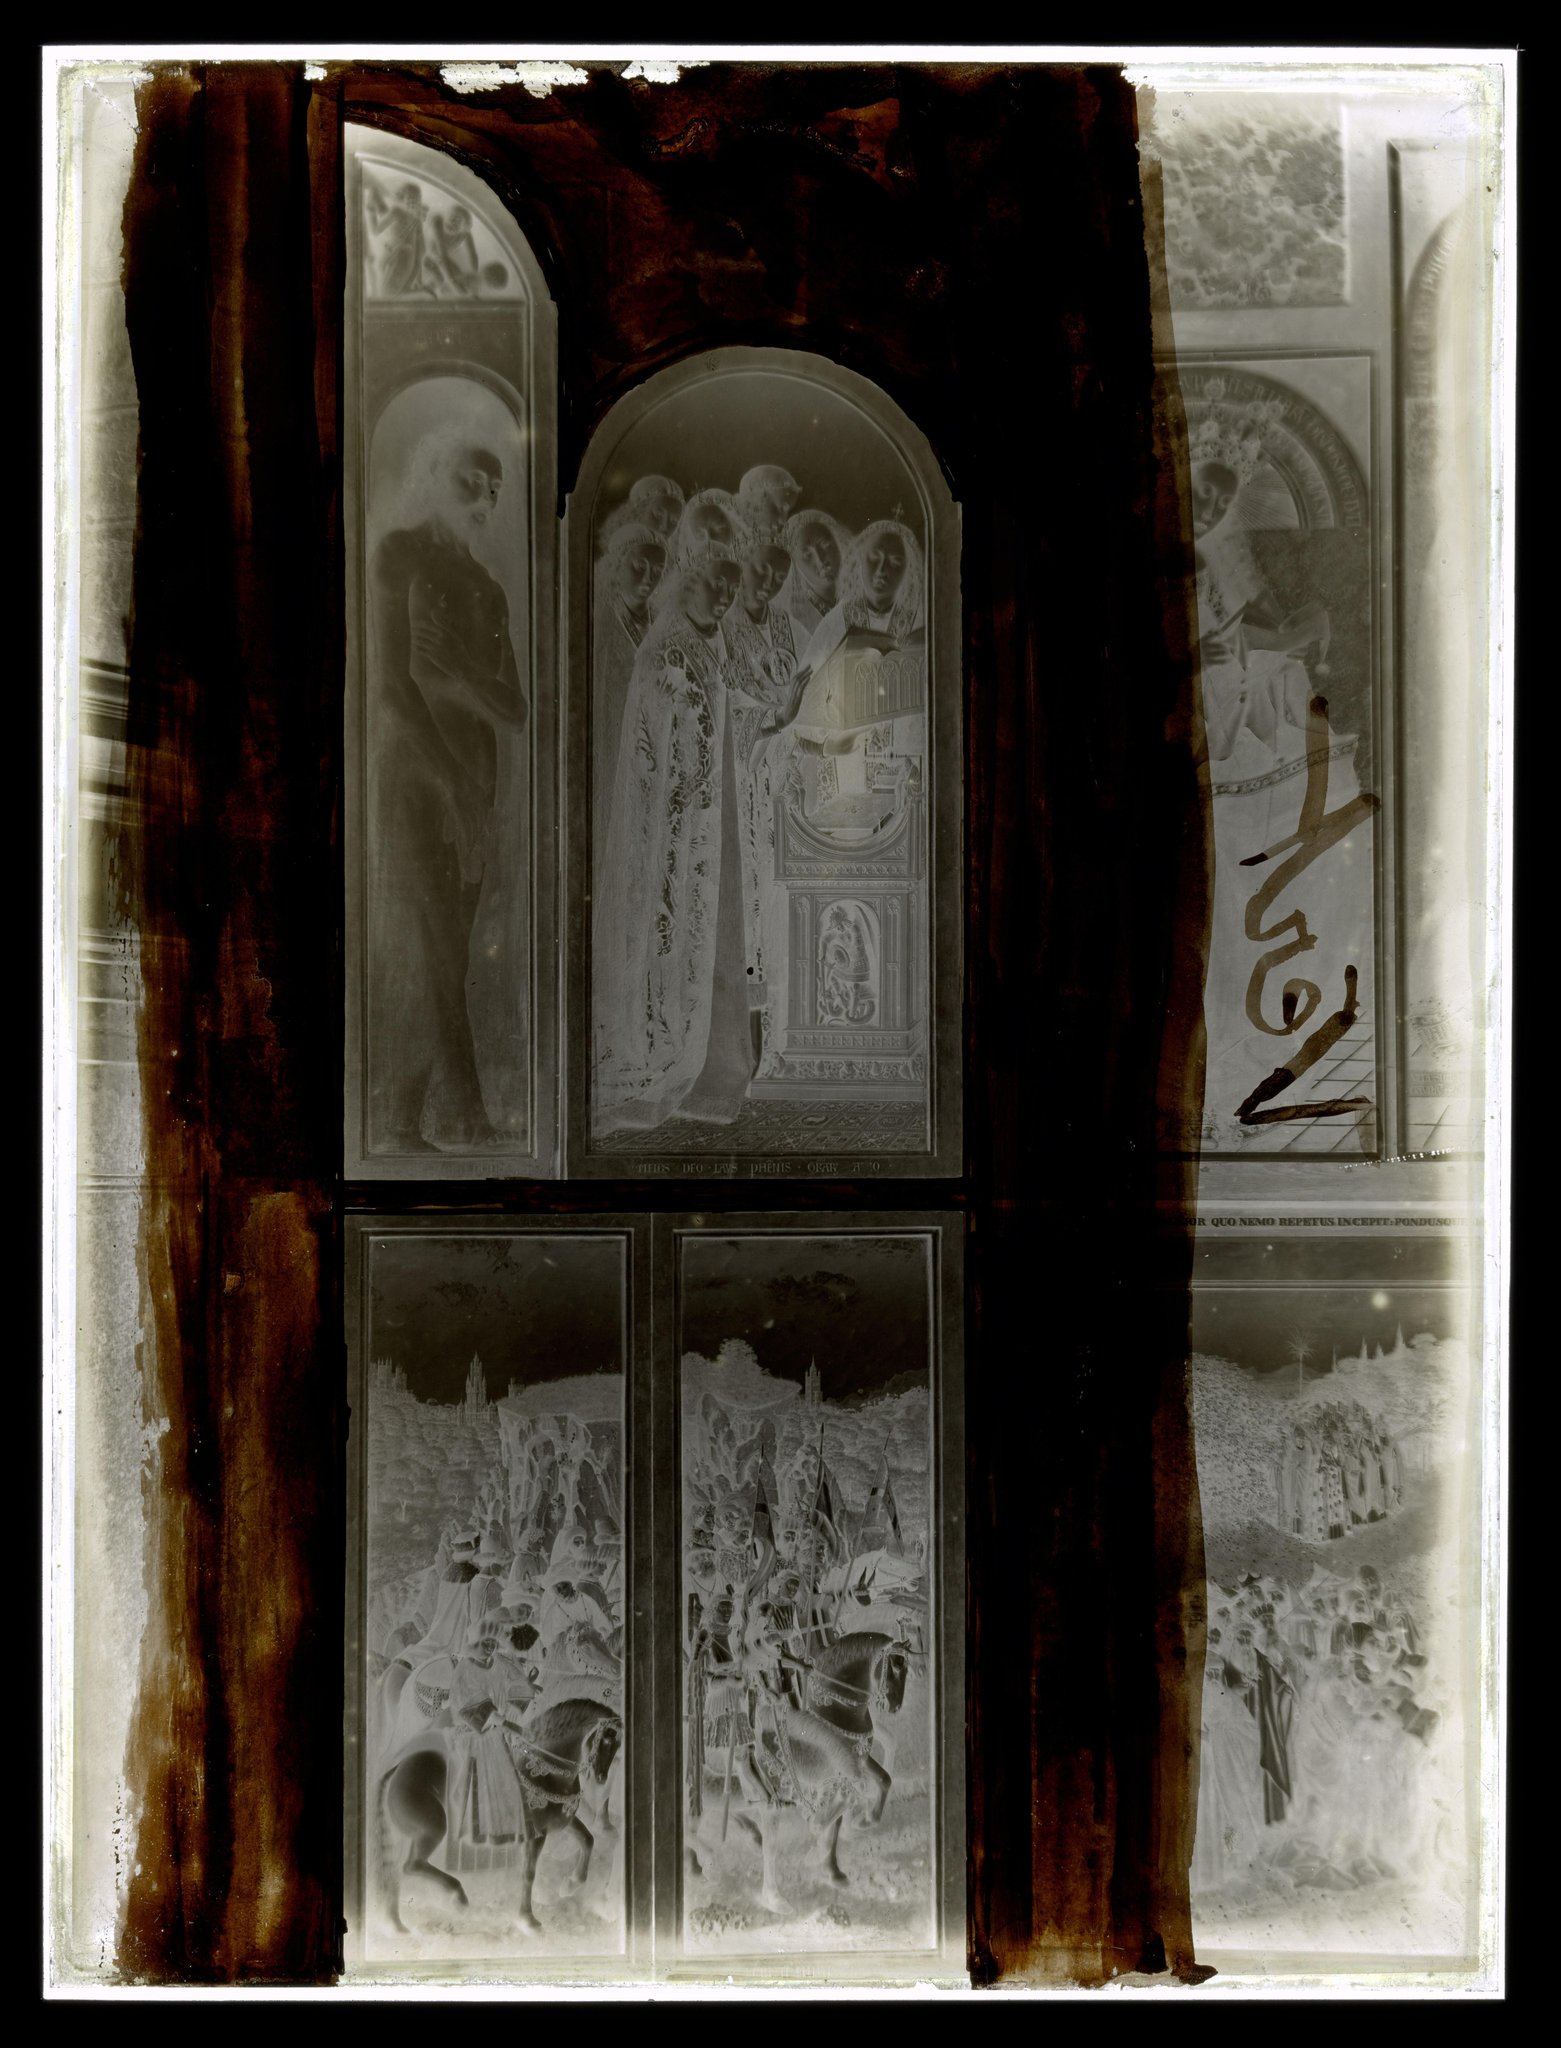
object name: negative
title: Deelnegatief van het linkerpaneel van het altaarstuk De aanbidding van het Lam Gods door Hubert en Jan van Eyck, opgesteld in de Sint-Baafskathedraal, Gent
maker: Anonymous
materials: glass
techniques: gelatin silver negative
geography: ghent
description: Gefotografeerd door een rood-, groen- en blauwfilter.